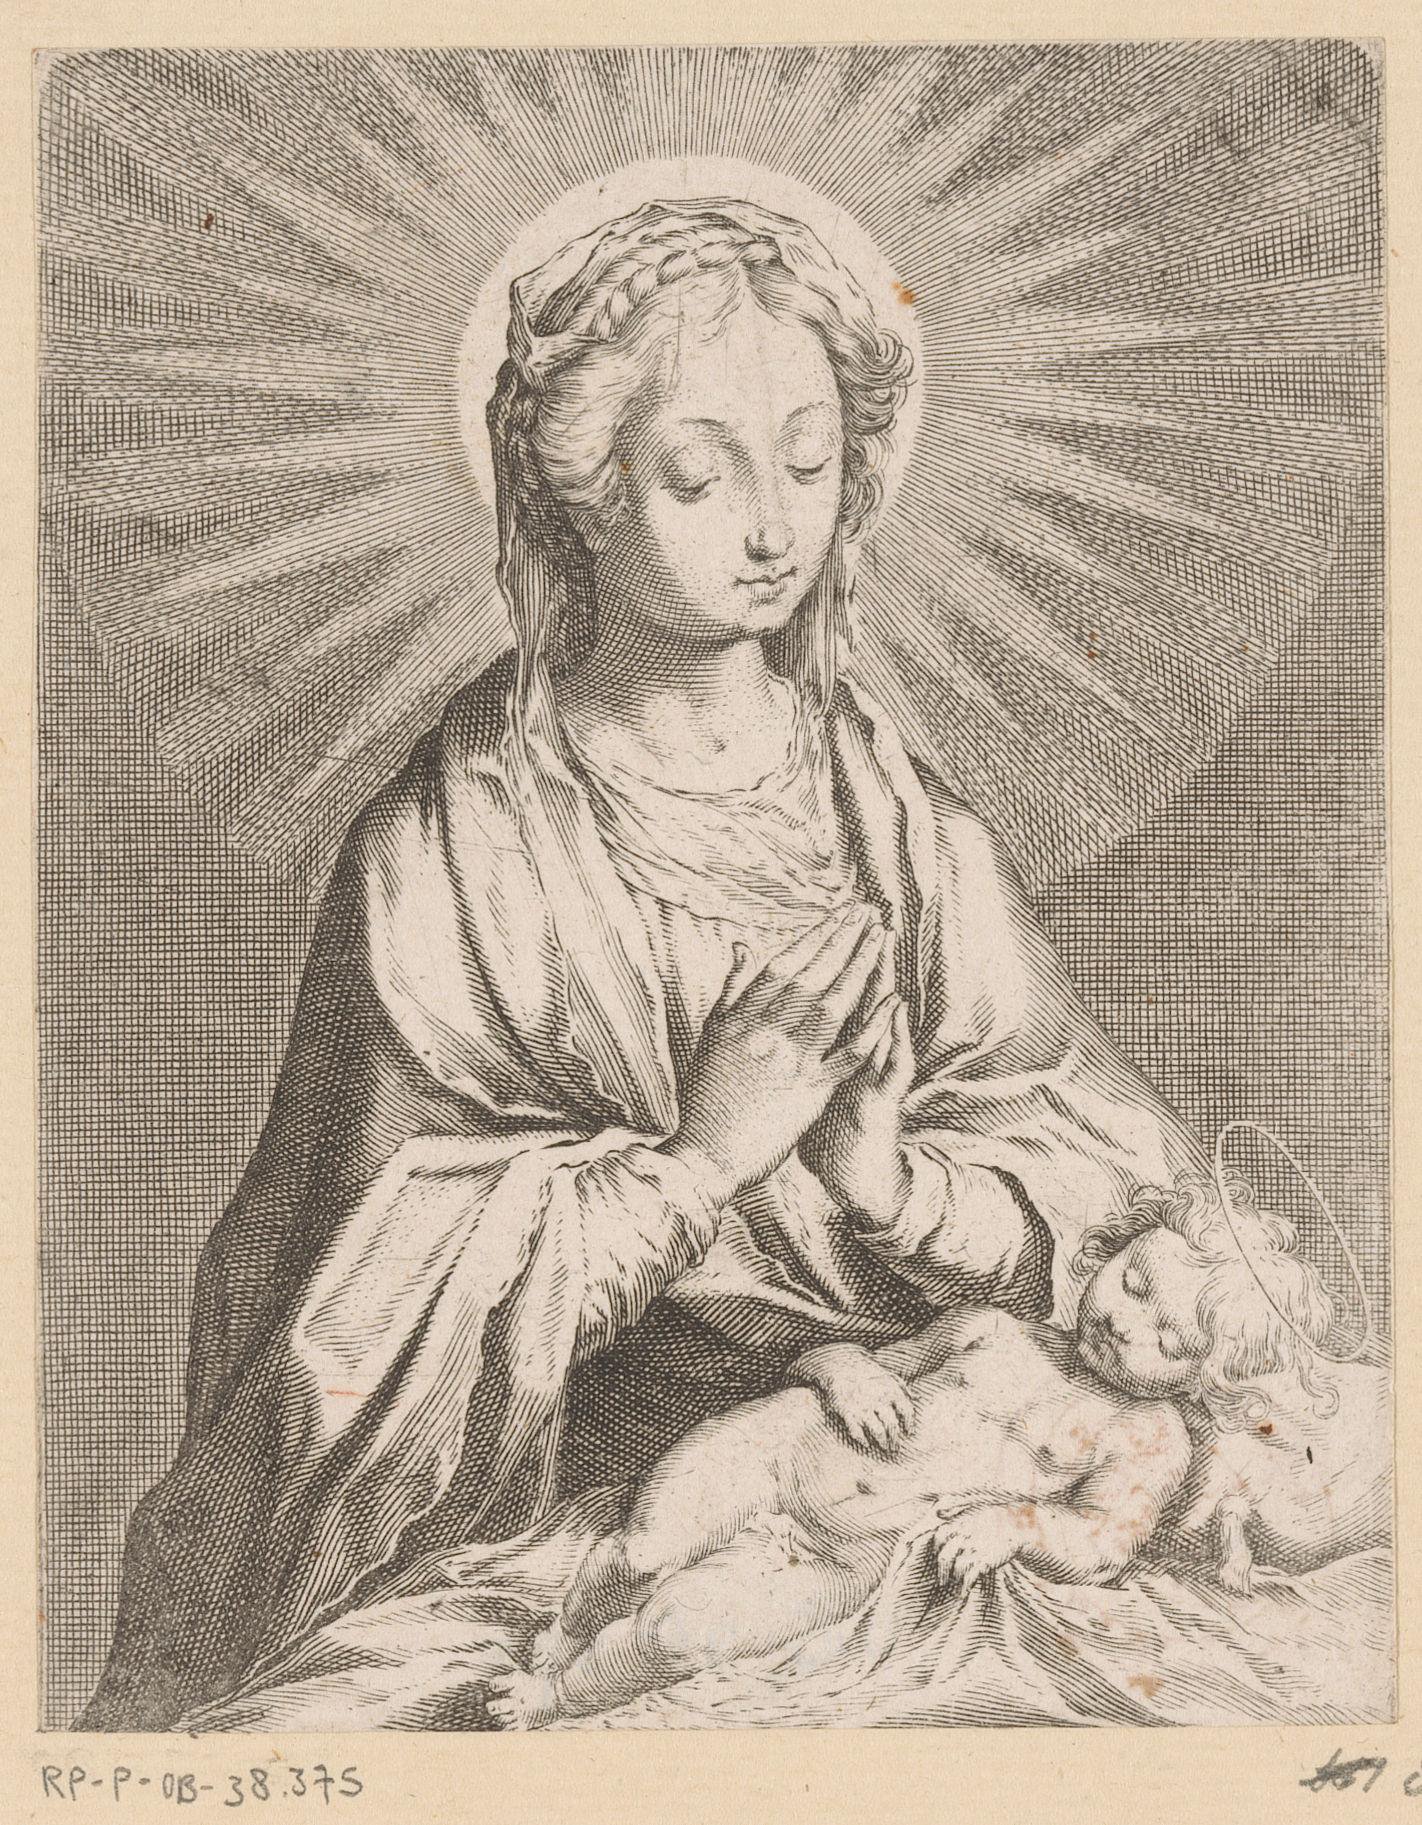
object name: print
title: Maria aanbidt het Christuskind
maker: francesco villamena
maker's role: draughtsman, painter, print maker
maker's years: 1566-1624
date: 1576-1624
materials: paper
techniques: engraving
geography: italy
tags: madonna: i.e. mary with the christ-child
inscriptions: collector's mark: Lugt 240